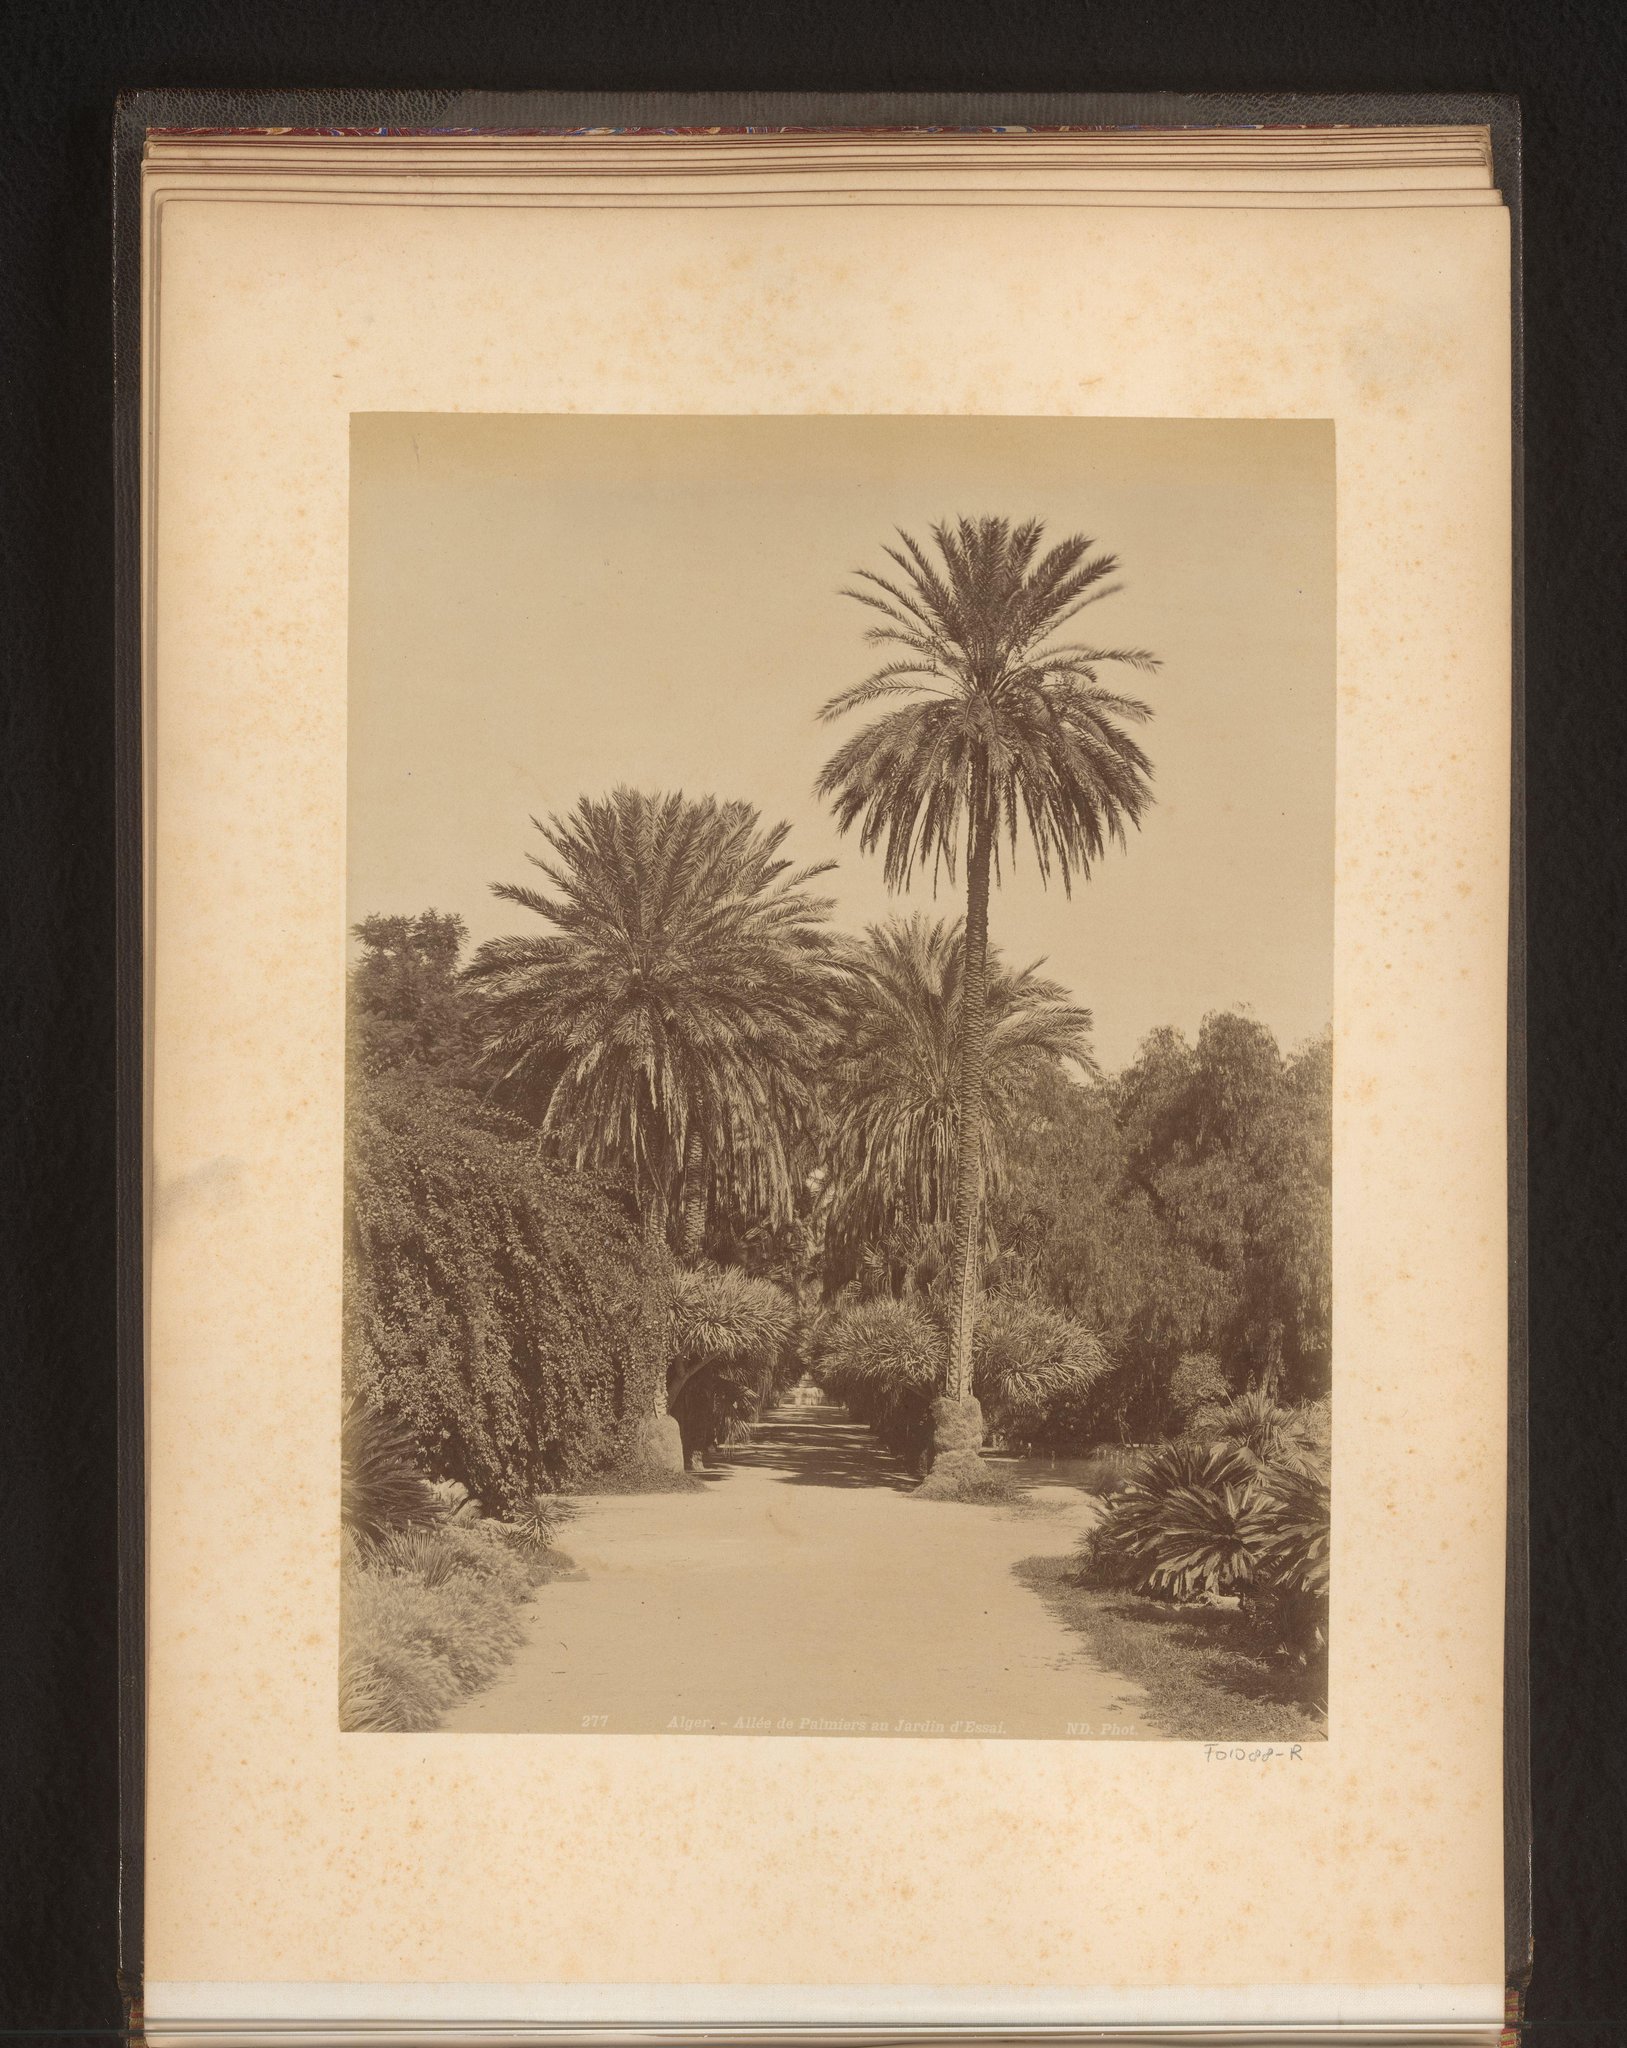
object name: photograph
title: Gezicht op Allee de Palmiers in Jardin d'essai du Hamma te Algiers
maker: étienne neurdein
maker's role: publisher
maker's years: 1832-1918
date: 1880-1900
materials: photographic support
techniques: albumen print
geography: algiers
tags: trees: palm-tree, botanic garden, 'hortus botanicus'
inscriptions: number: ‘277’